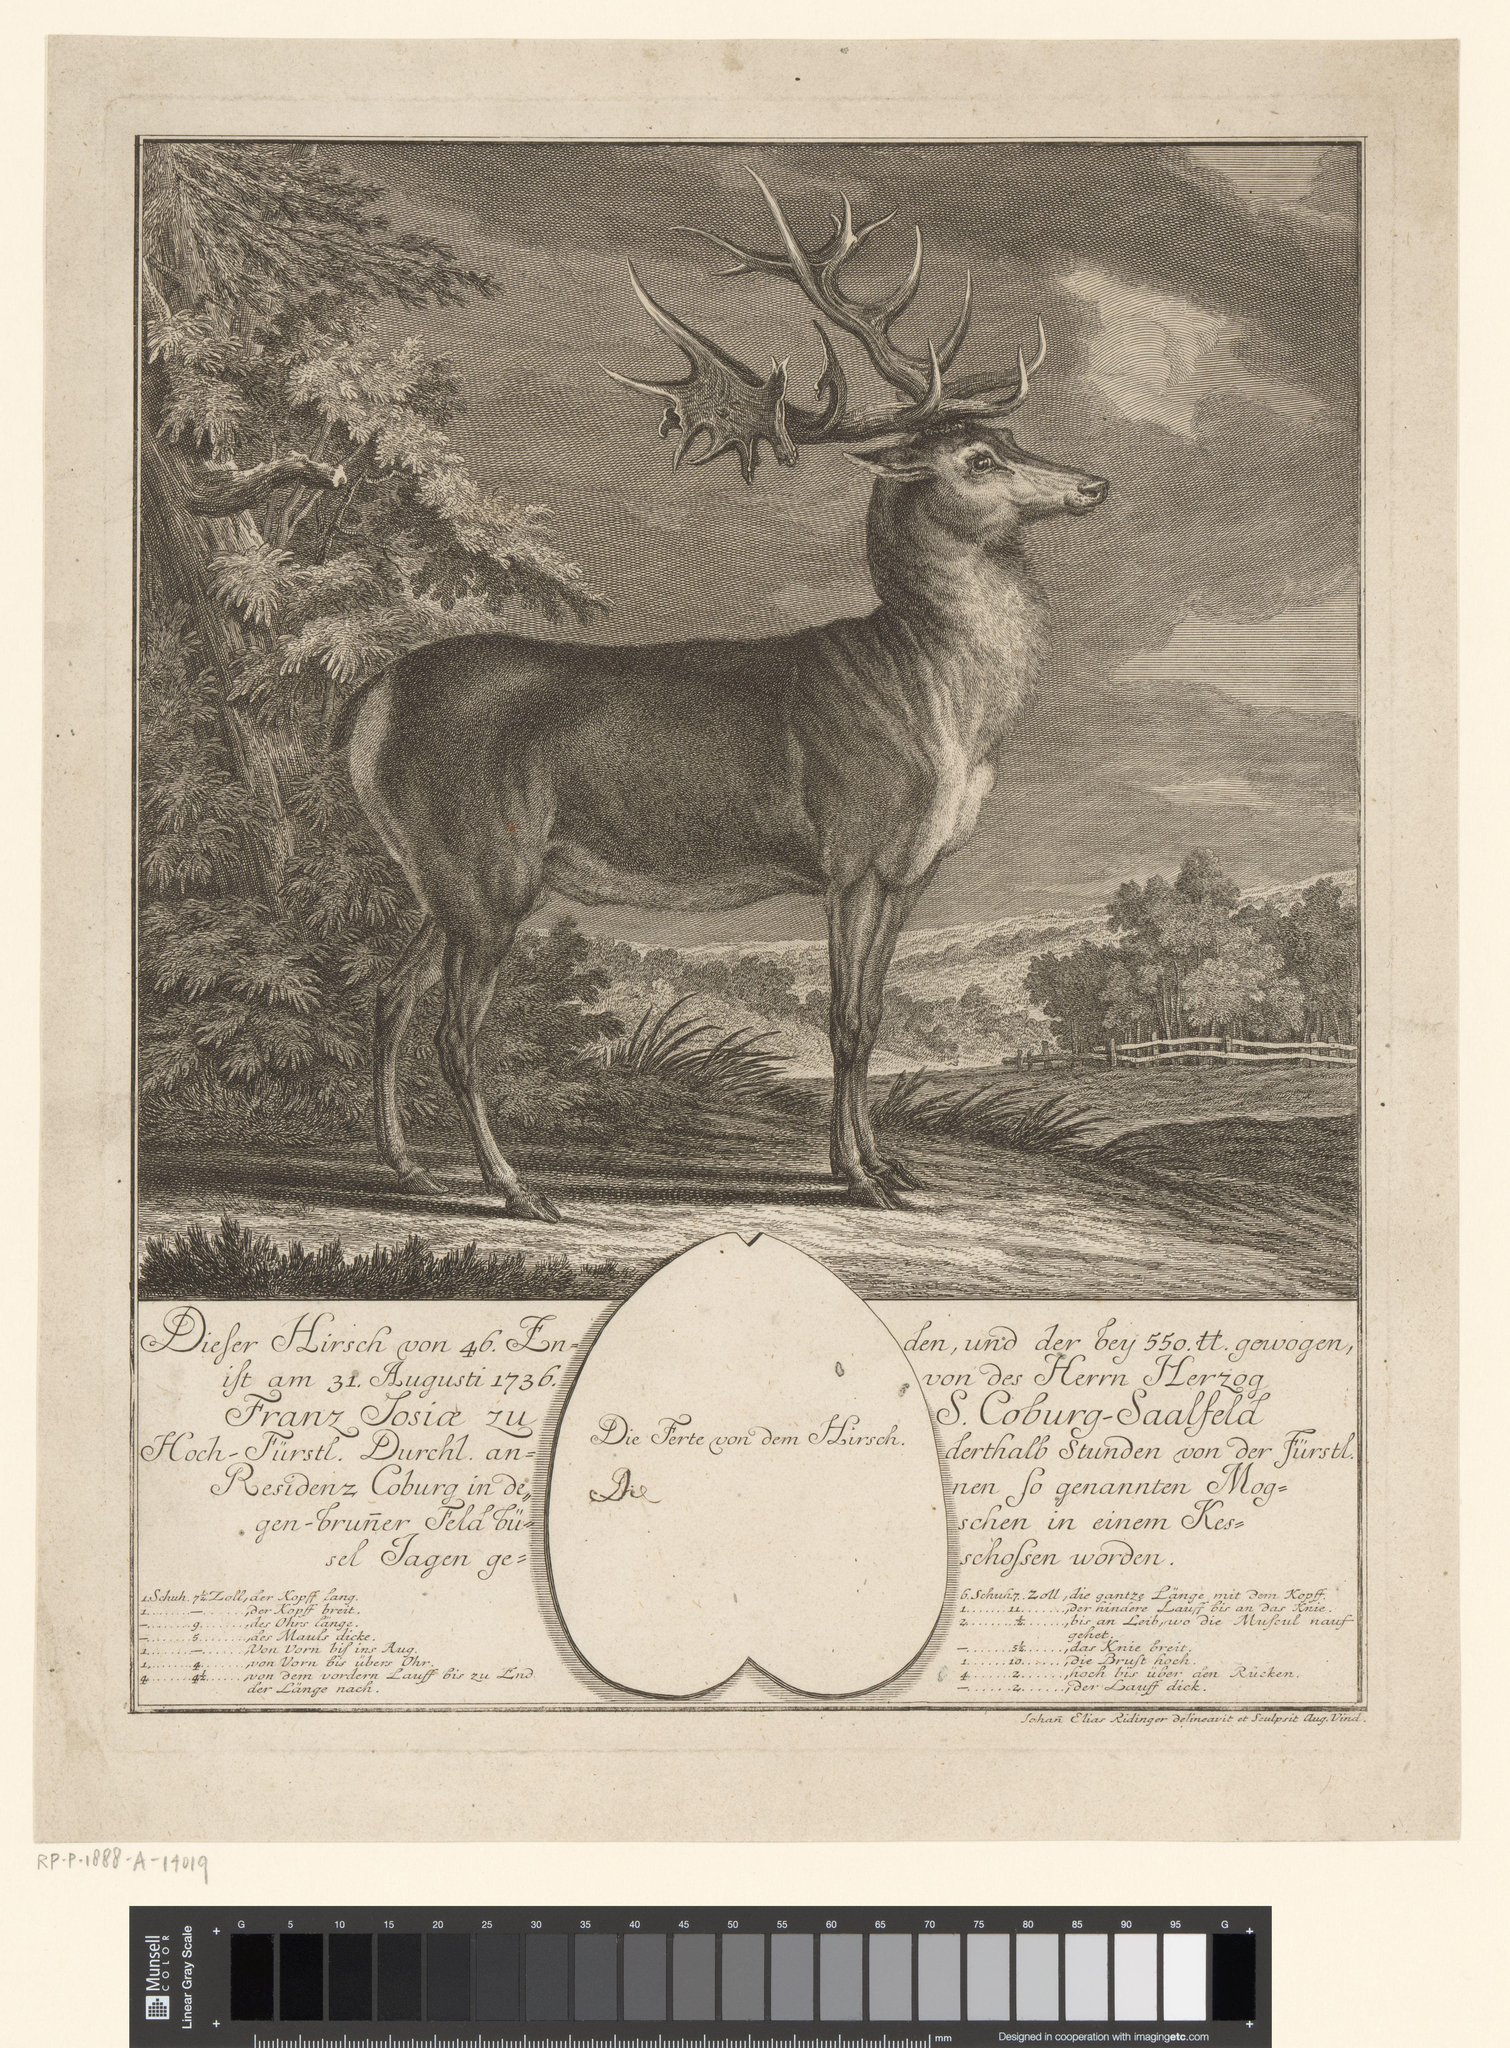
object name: print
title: De 100 meest wonderlijke herten en andere dieren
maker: johann elias ridinger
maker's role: draughtsman, painter, print maker, publisher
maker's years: 1698-1767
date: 1740-1767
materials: paper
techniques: engraving, etching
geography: augsburg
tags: hoofed animals: deer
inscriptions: collector's mark: Lugt 2228, : ‘Die’